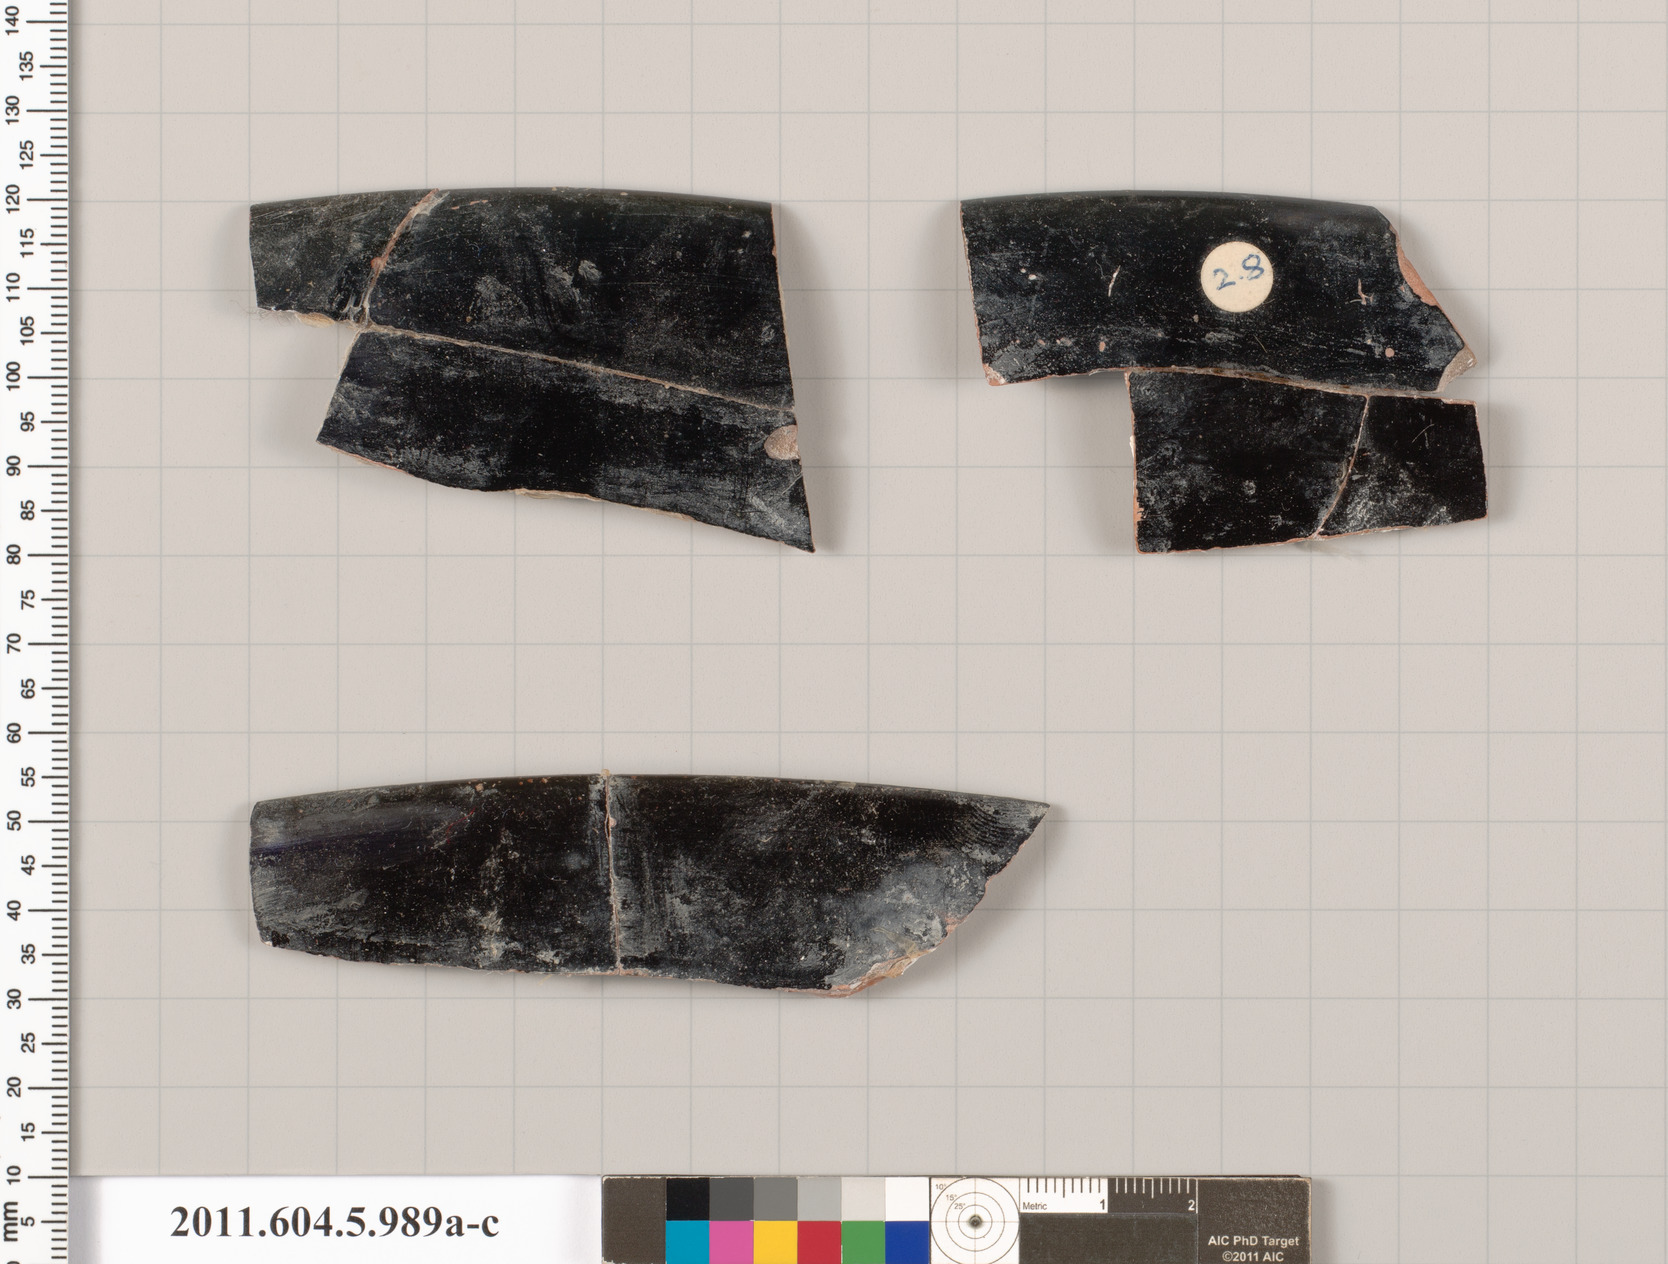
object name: kylix fragment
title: Terracotta rim fragments of a kylix (drinking cup)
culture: greek, attic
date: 600-401 BCE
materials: terracotta